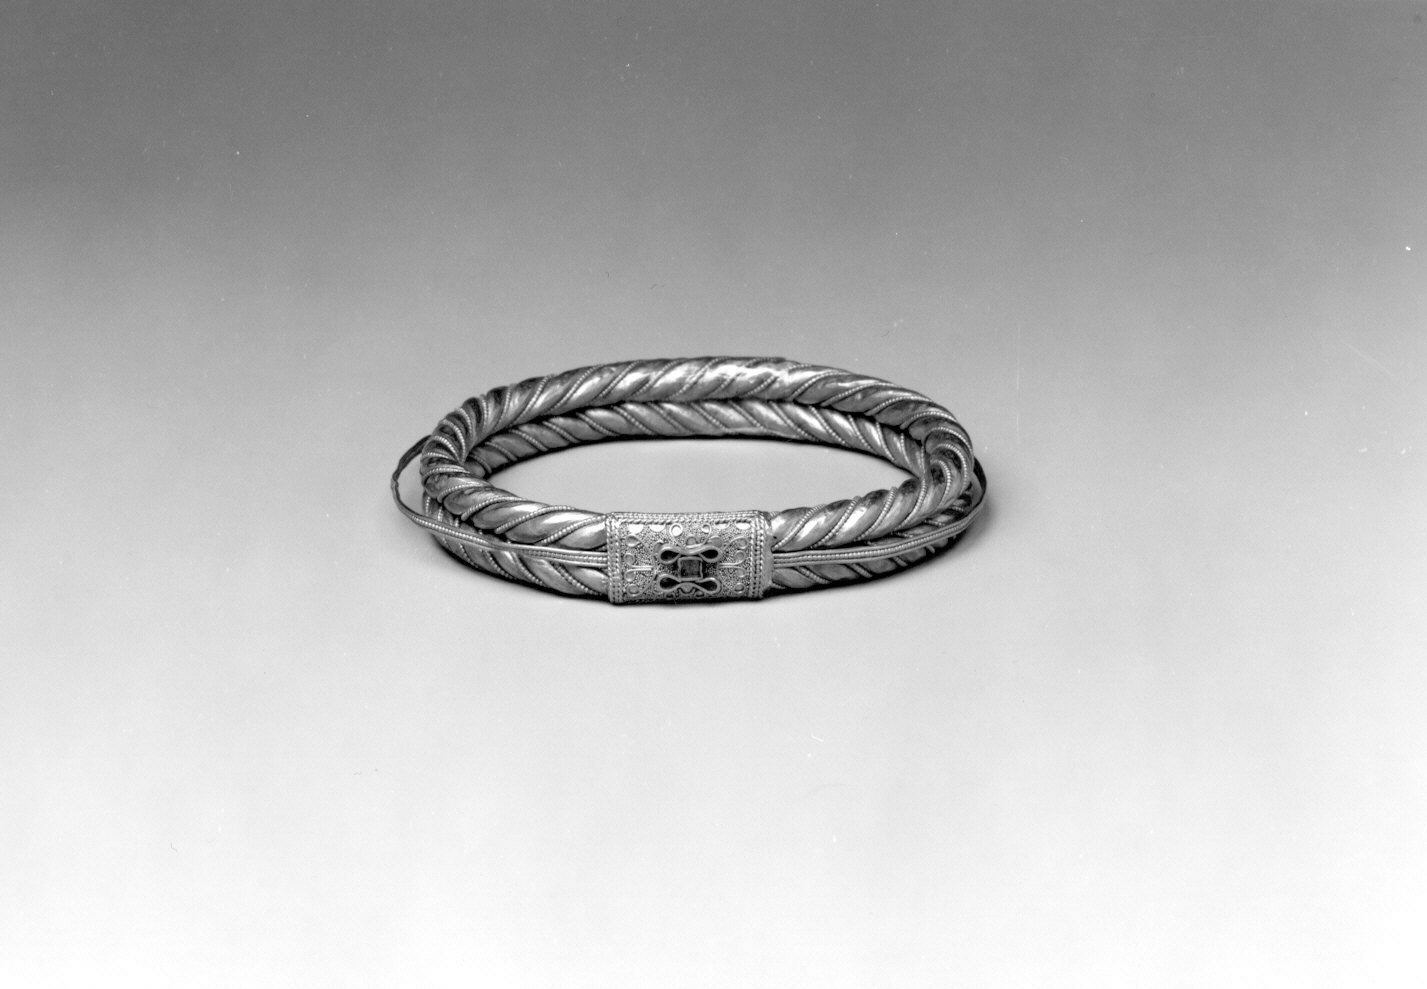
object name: bracelet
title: Pair of bracelets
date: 500-301 BCE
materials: amber, gold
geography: iberian peninsula